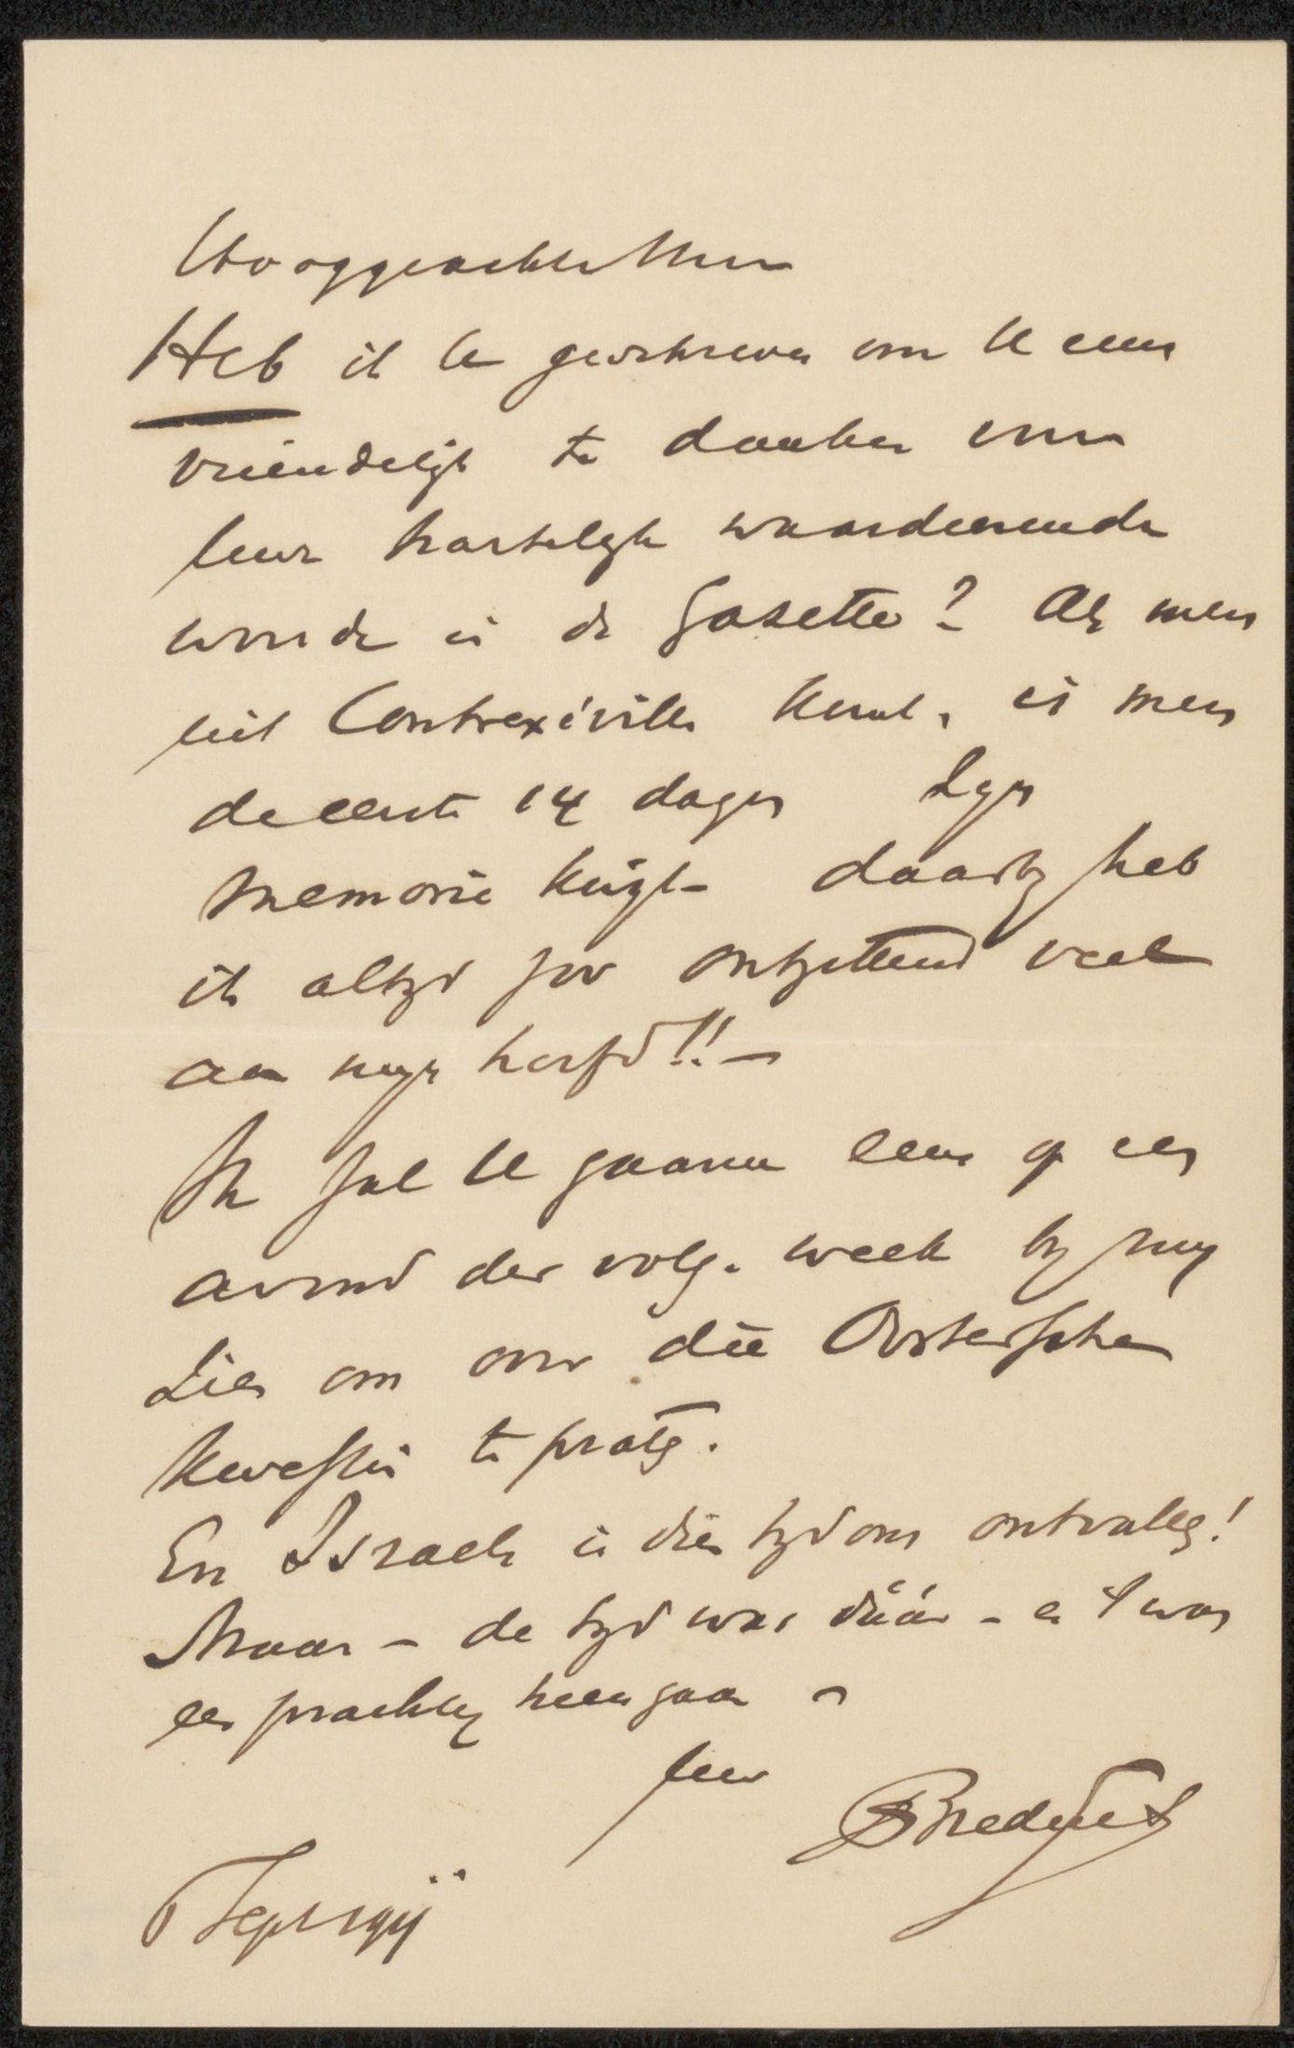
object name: letter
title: Brief aan Philip Zilcken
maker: abraham bredius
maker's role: kunsthistoricus, museumdirecteur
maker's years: 1855-1946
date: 1911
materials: ink, paper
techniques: pen, writing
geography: the hague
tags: print maker, draughtsman, jozef israëls, philip zilcken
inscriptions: collector's mark: ‘RPK’